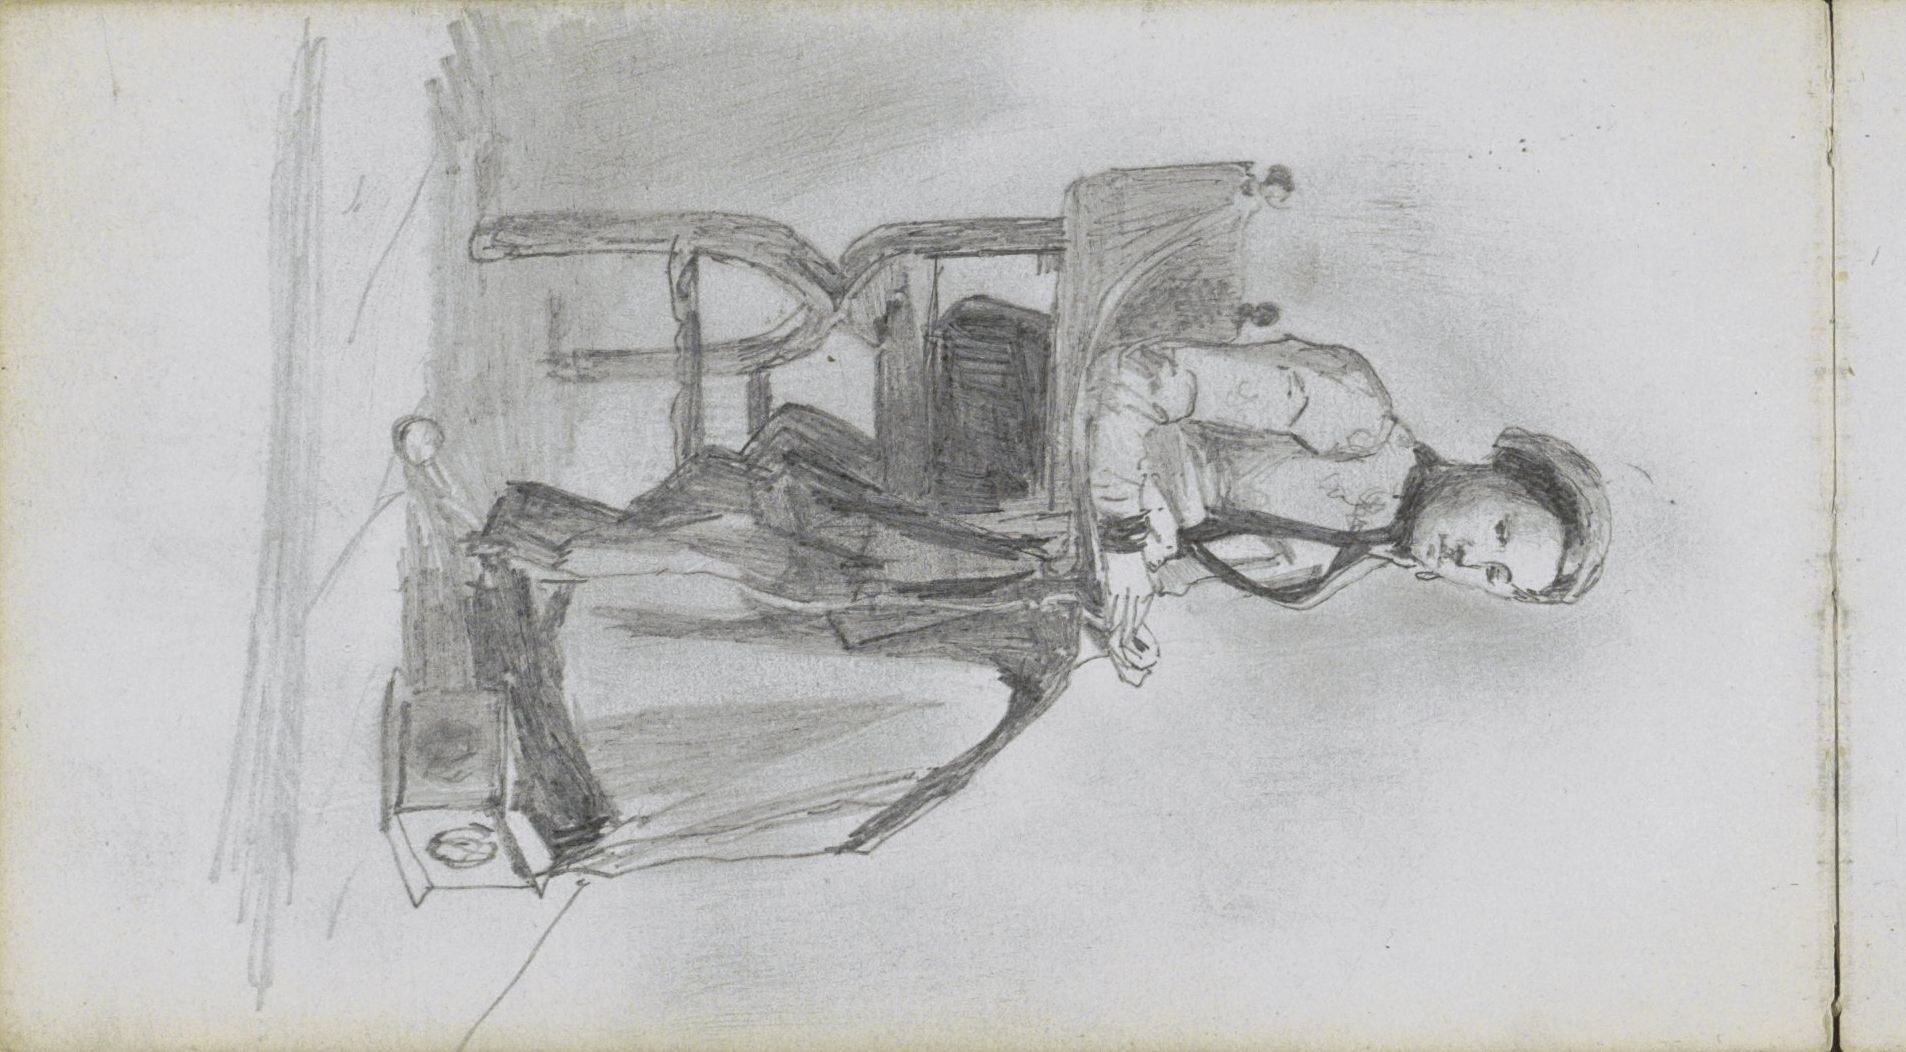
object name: sketchbook leaf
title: Breiende vrouw met de voeten op een stoof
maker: johan hendrik weissenbruch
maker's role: draughtsman, painter, print maker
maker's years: 1824-1903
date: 1834-1903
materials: paper, pencil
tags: footstool, sitting figure (+ female (human being) (not to be used where -aa- is prescribed)), knitting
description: Blad 35 verso uit een schetsboek met 39 bladen.